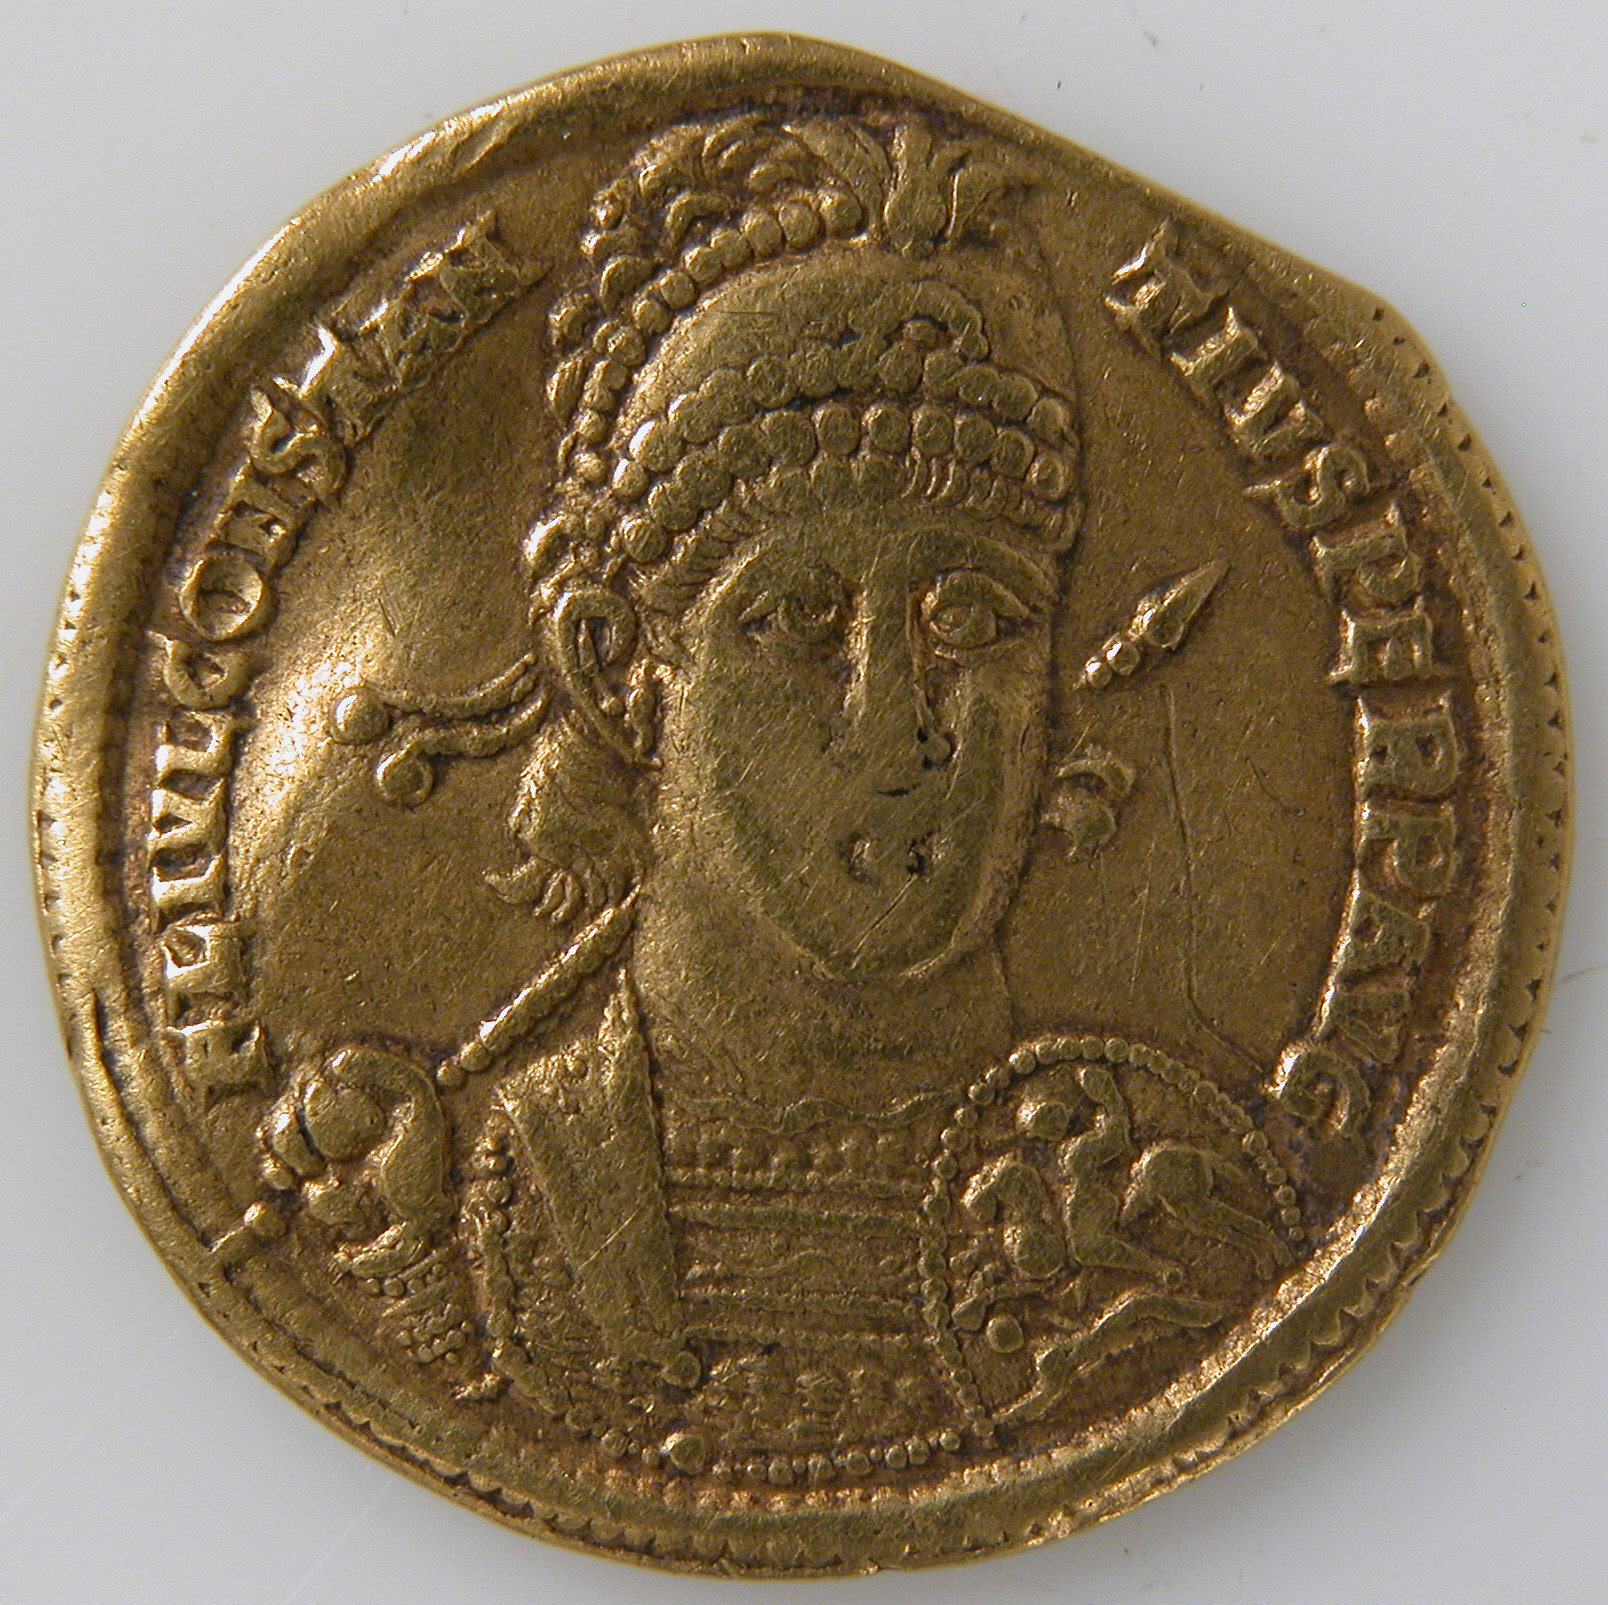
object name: solidus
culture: byzantine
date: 349-359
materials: gold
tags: men